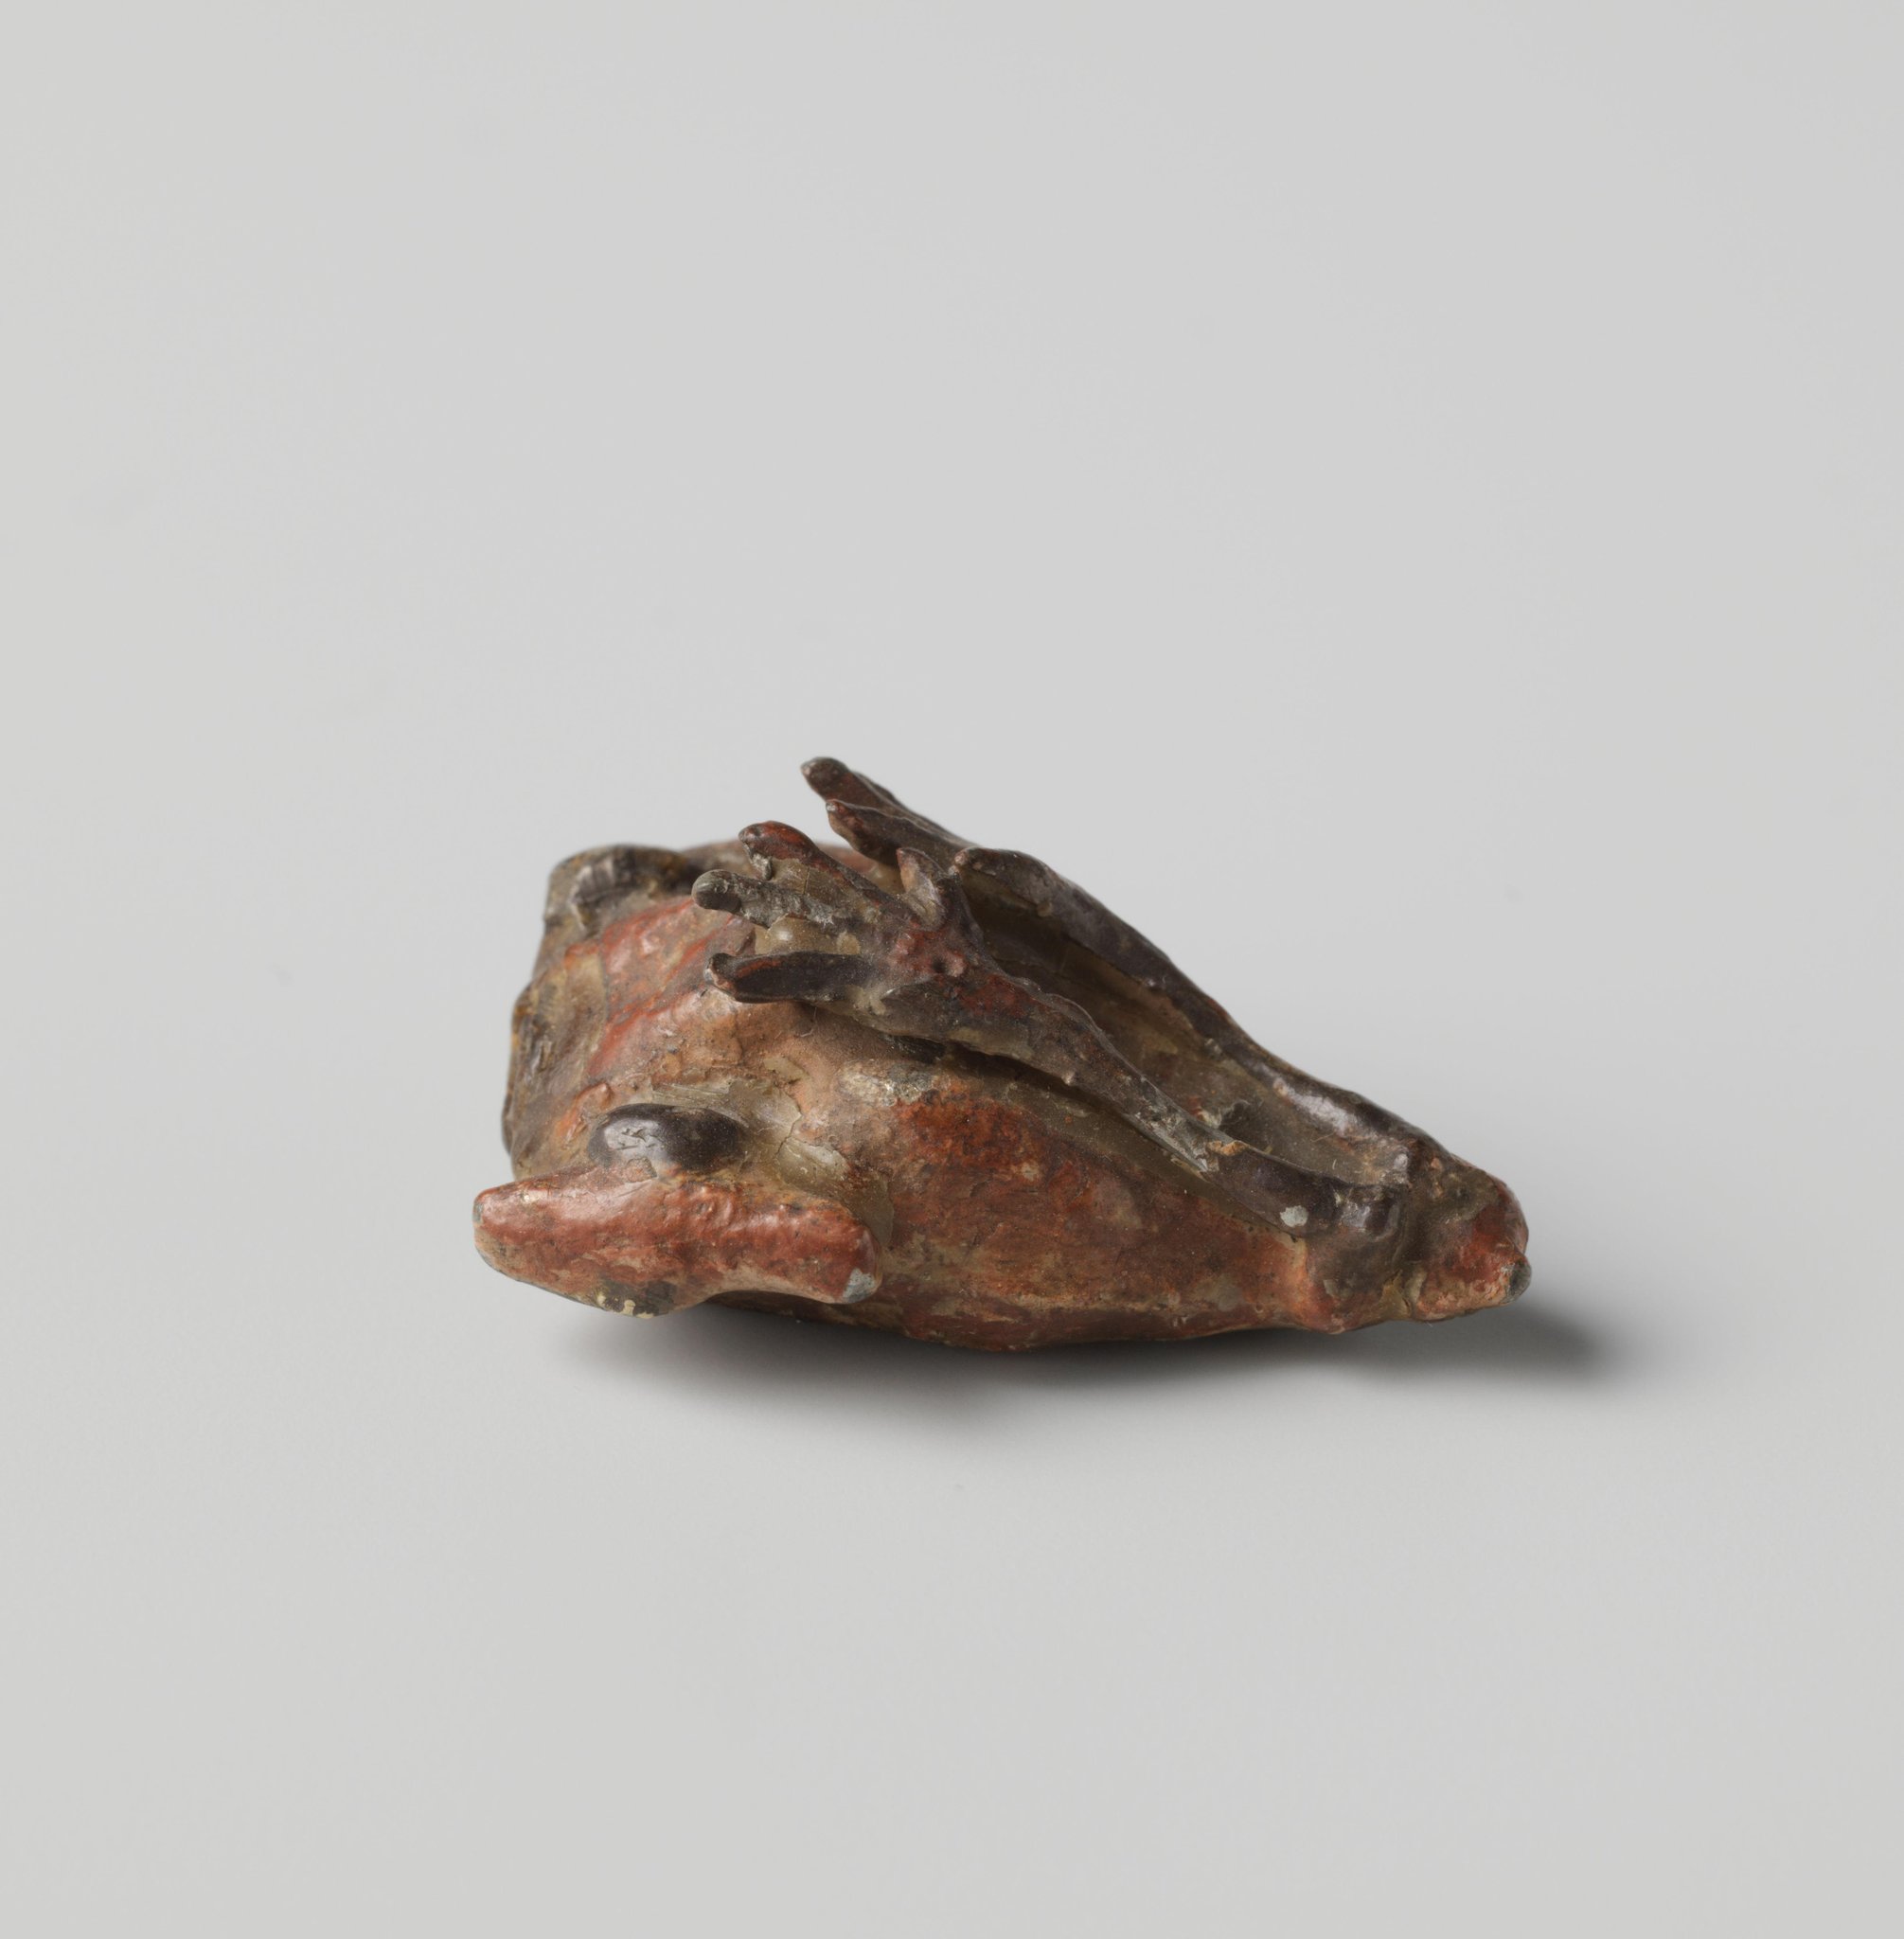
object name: food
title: Gebraden kalkoen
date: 1700-1799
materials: tin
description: Kalkoen van metaal, hol, met roodbruin beschilderde romp, de vleugels opgebonden. De poten steken in de lucht.